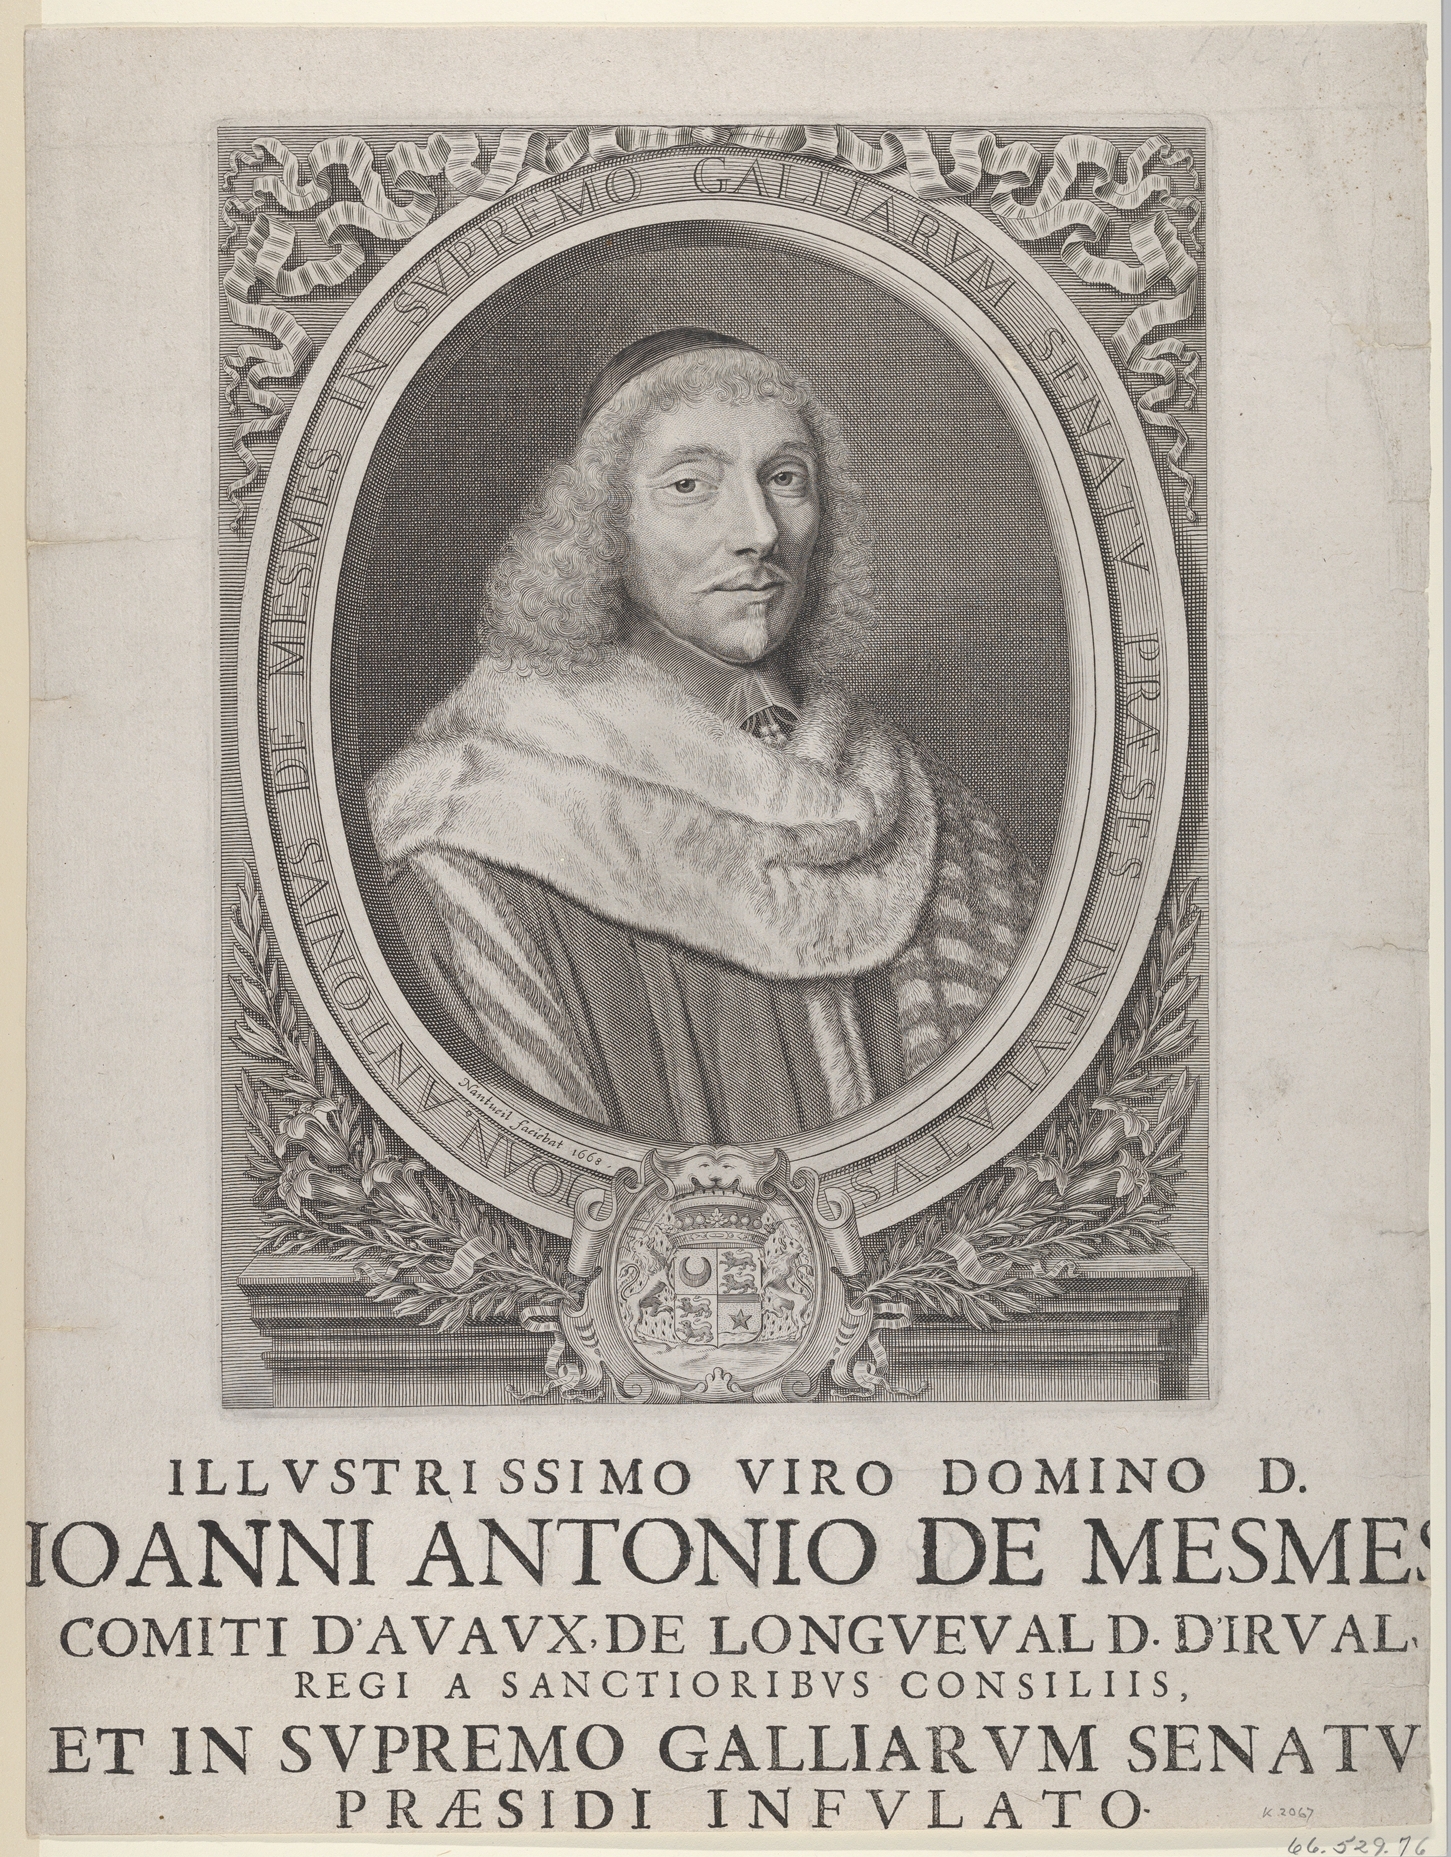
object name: print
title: Jean-Antoine de Mesmes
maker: robert nanteuil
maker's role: artist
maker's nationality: french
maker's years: 1623-1678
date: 1658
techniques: engraving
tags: men,portraits,coat of arms